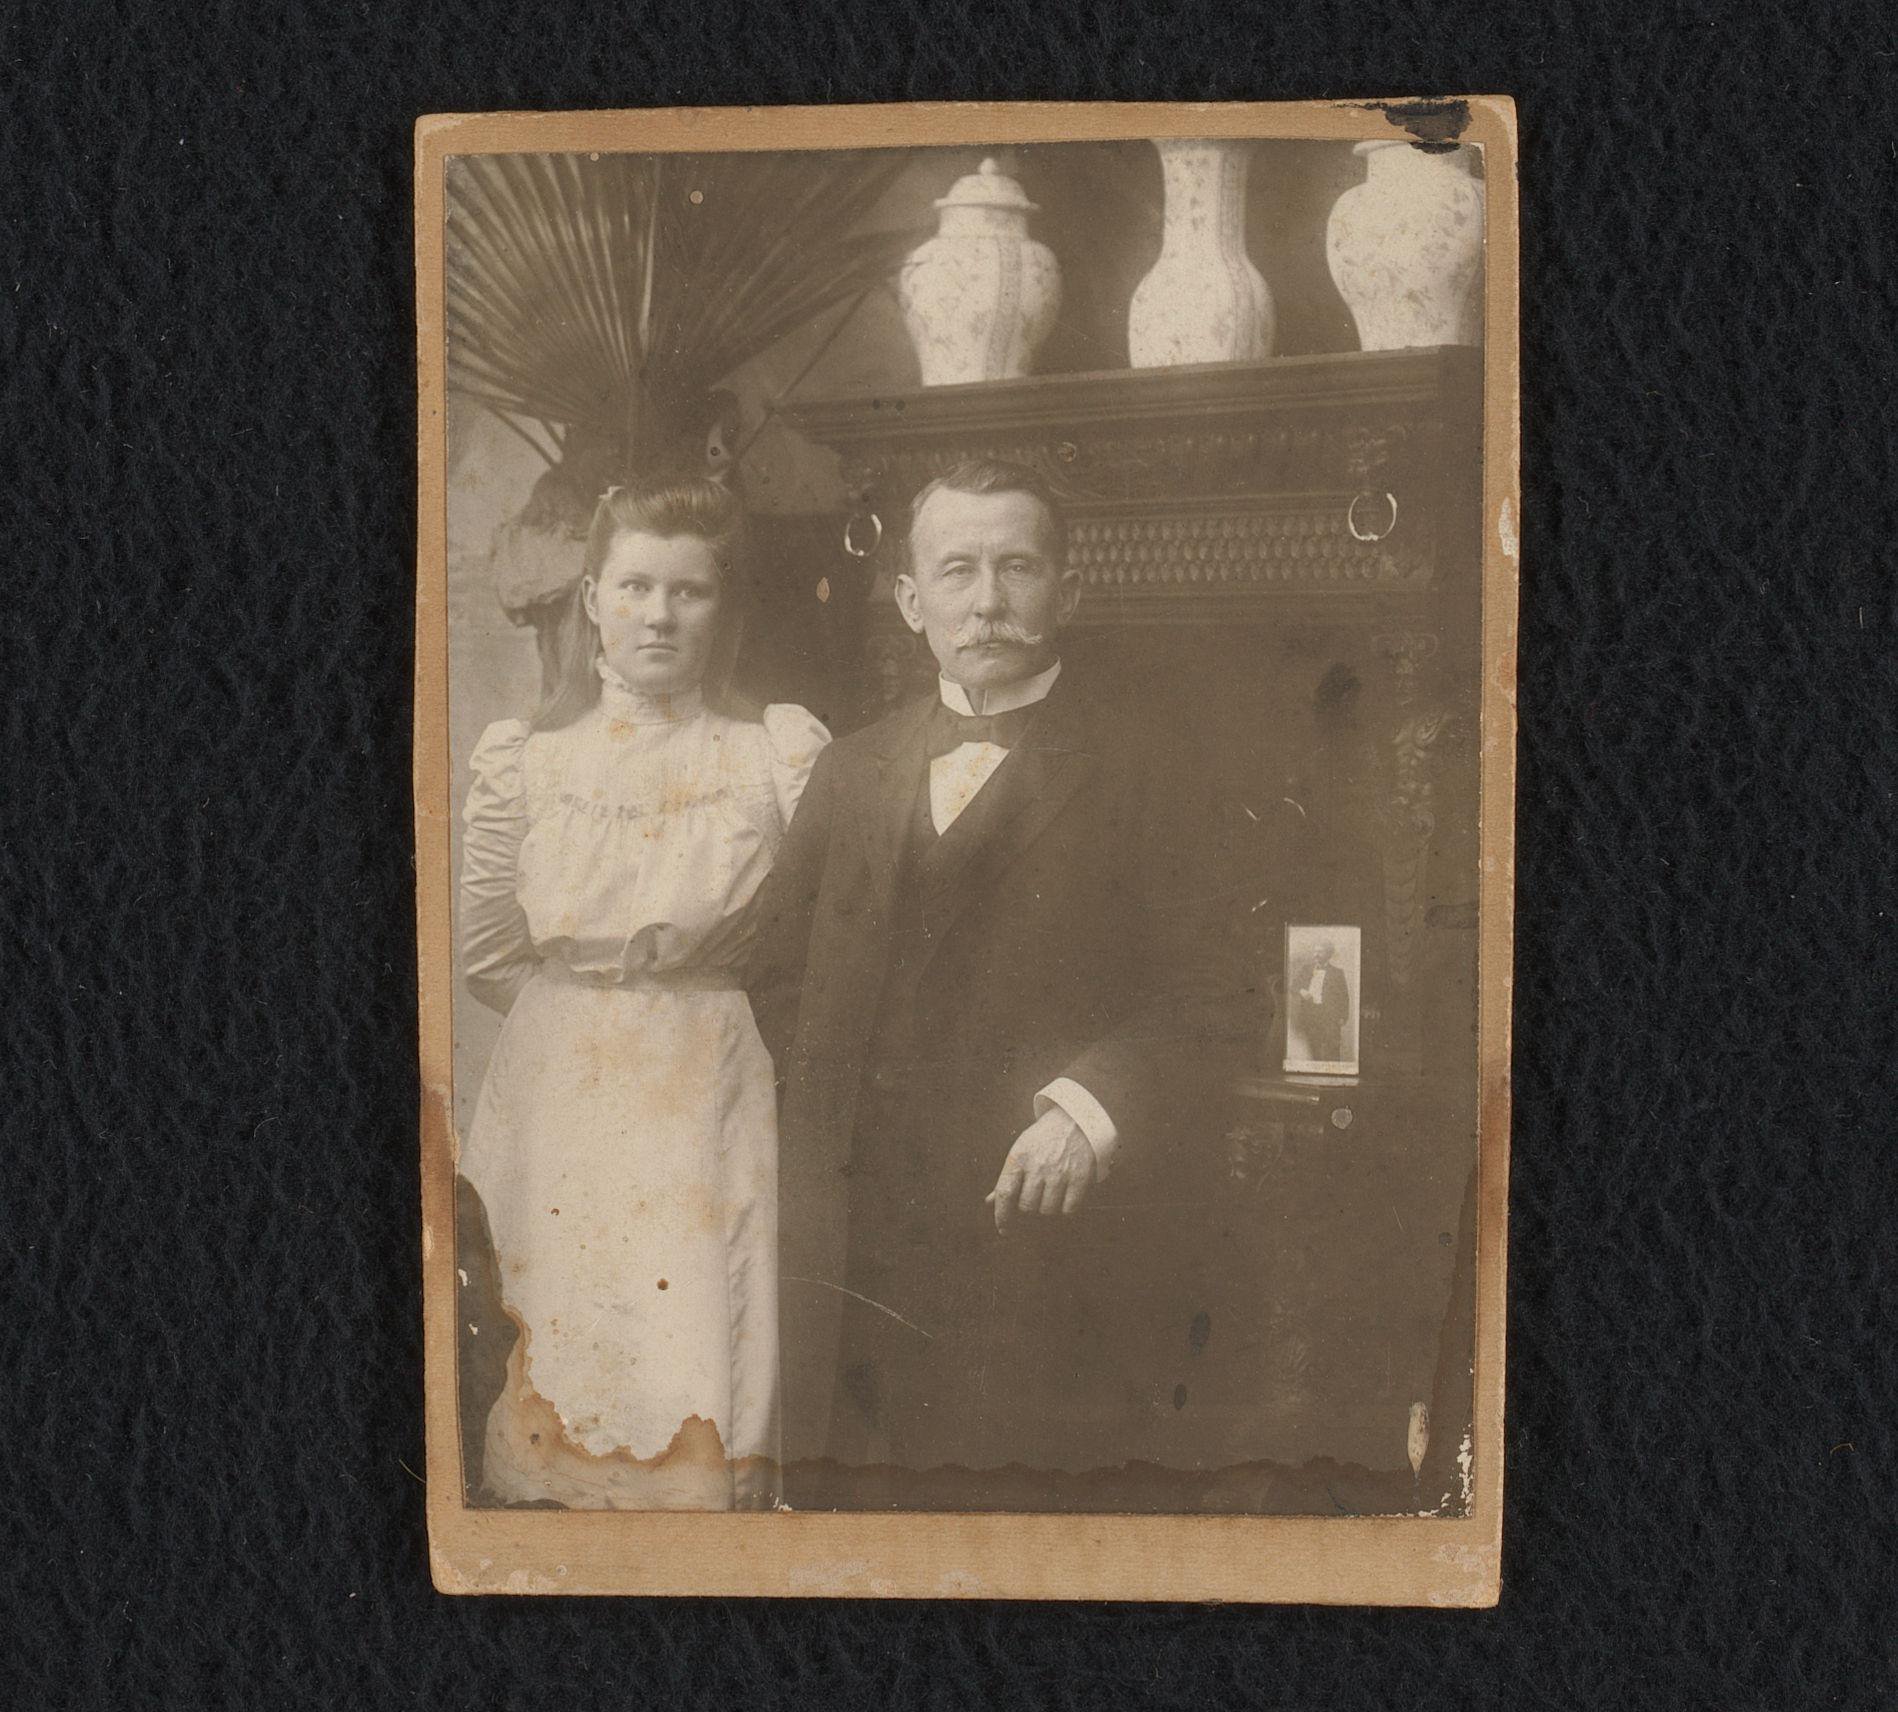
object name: photograph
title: August en An Kessler, poserend naast een carte-de-visiteportret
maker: jean baptiste august kessler (1853-1900)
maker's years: 1853-1900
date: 1895-1900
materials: paper, cardboard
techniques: gelatin silver print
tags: batavia, naples, jean baptiste august kessler (1853-1900), father and daughter(s) (family group)